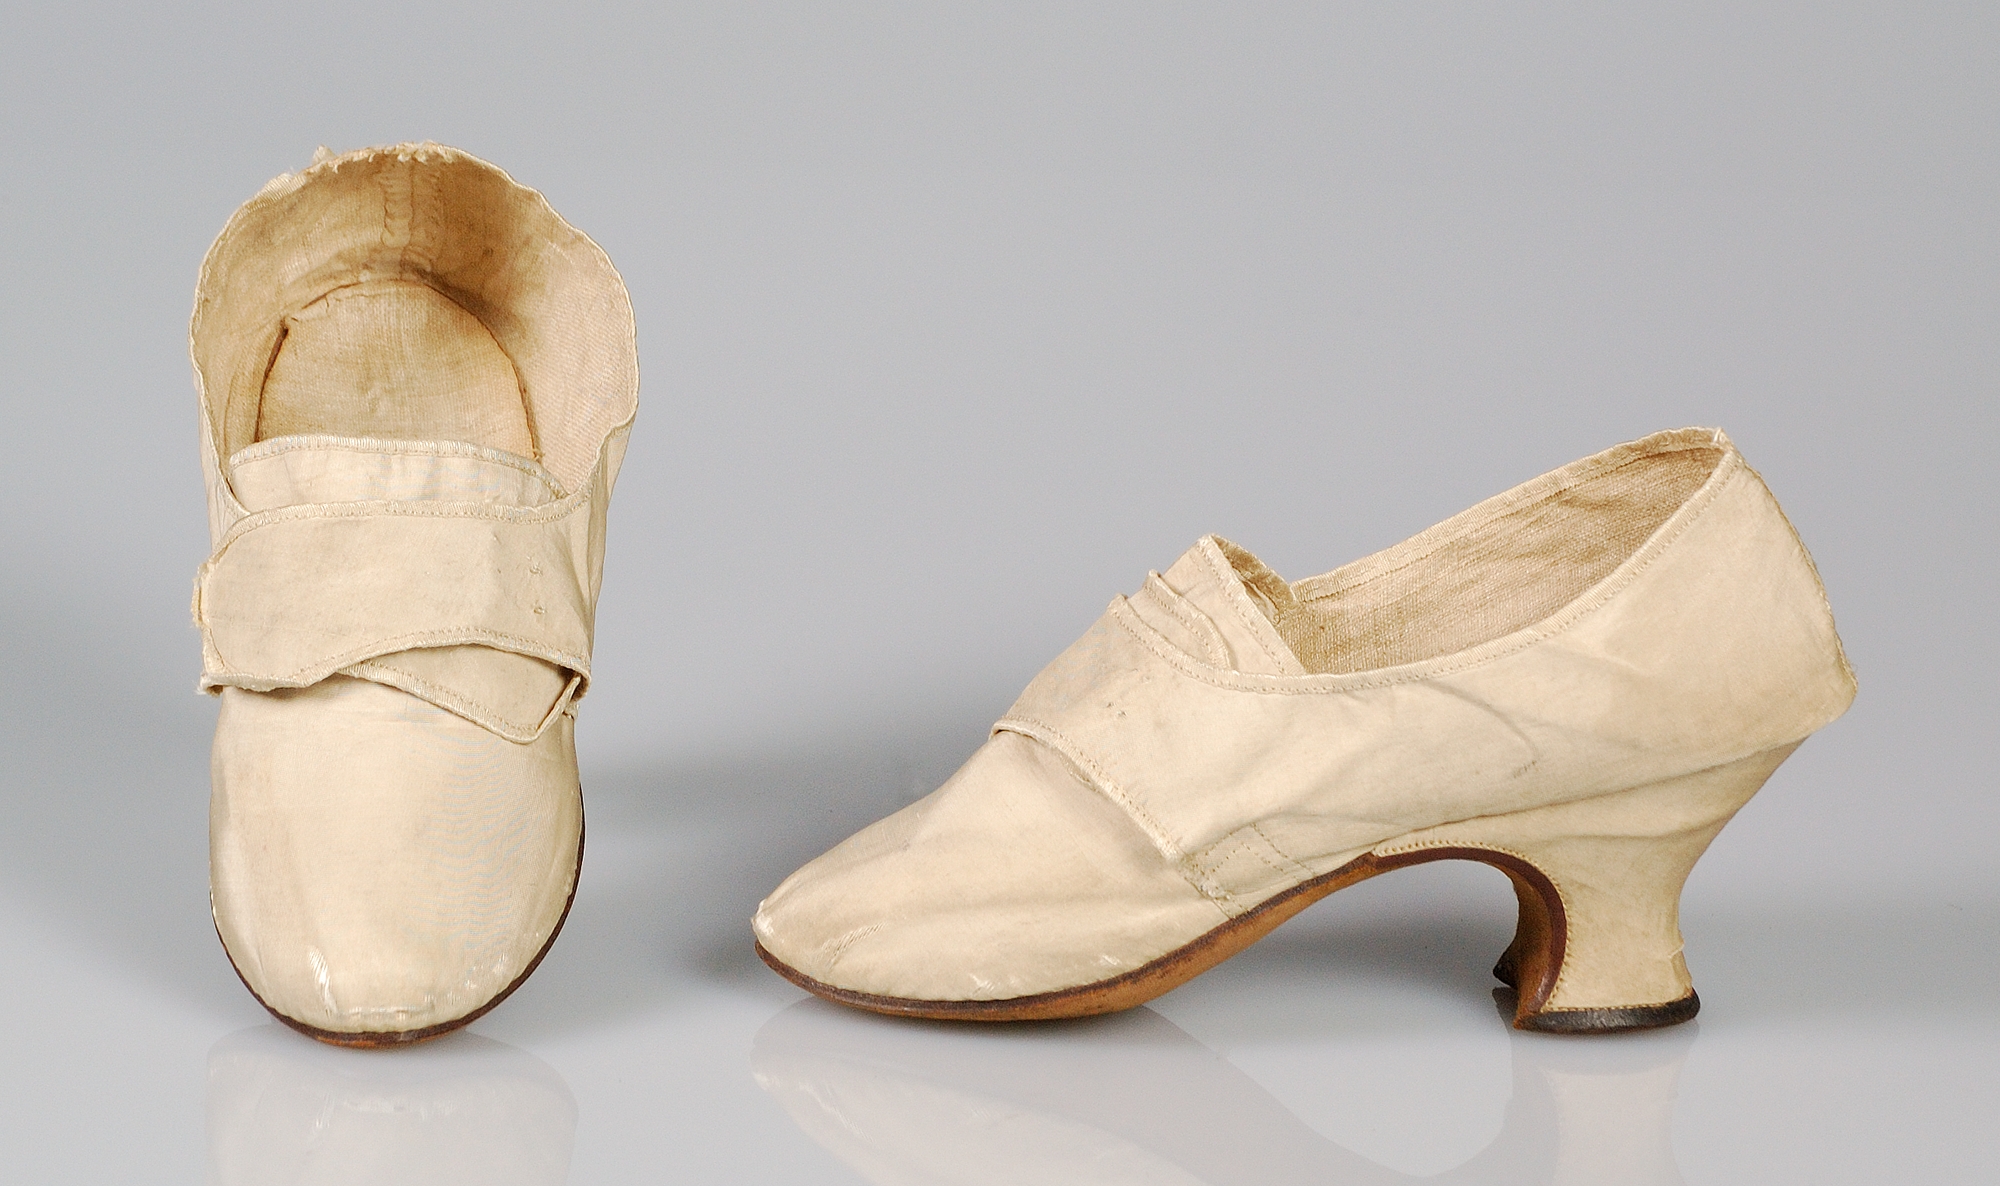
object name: shoe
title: Shoes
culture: british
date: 1750-1769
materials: silk